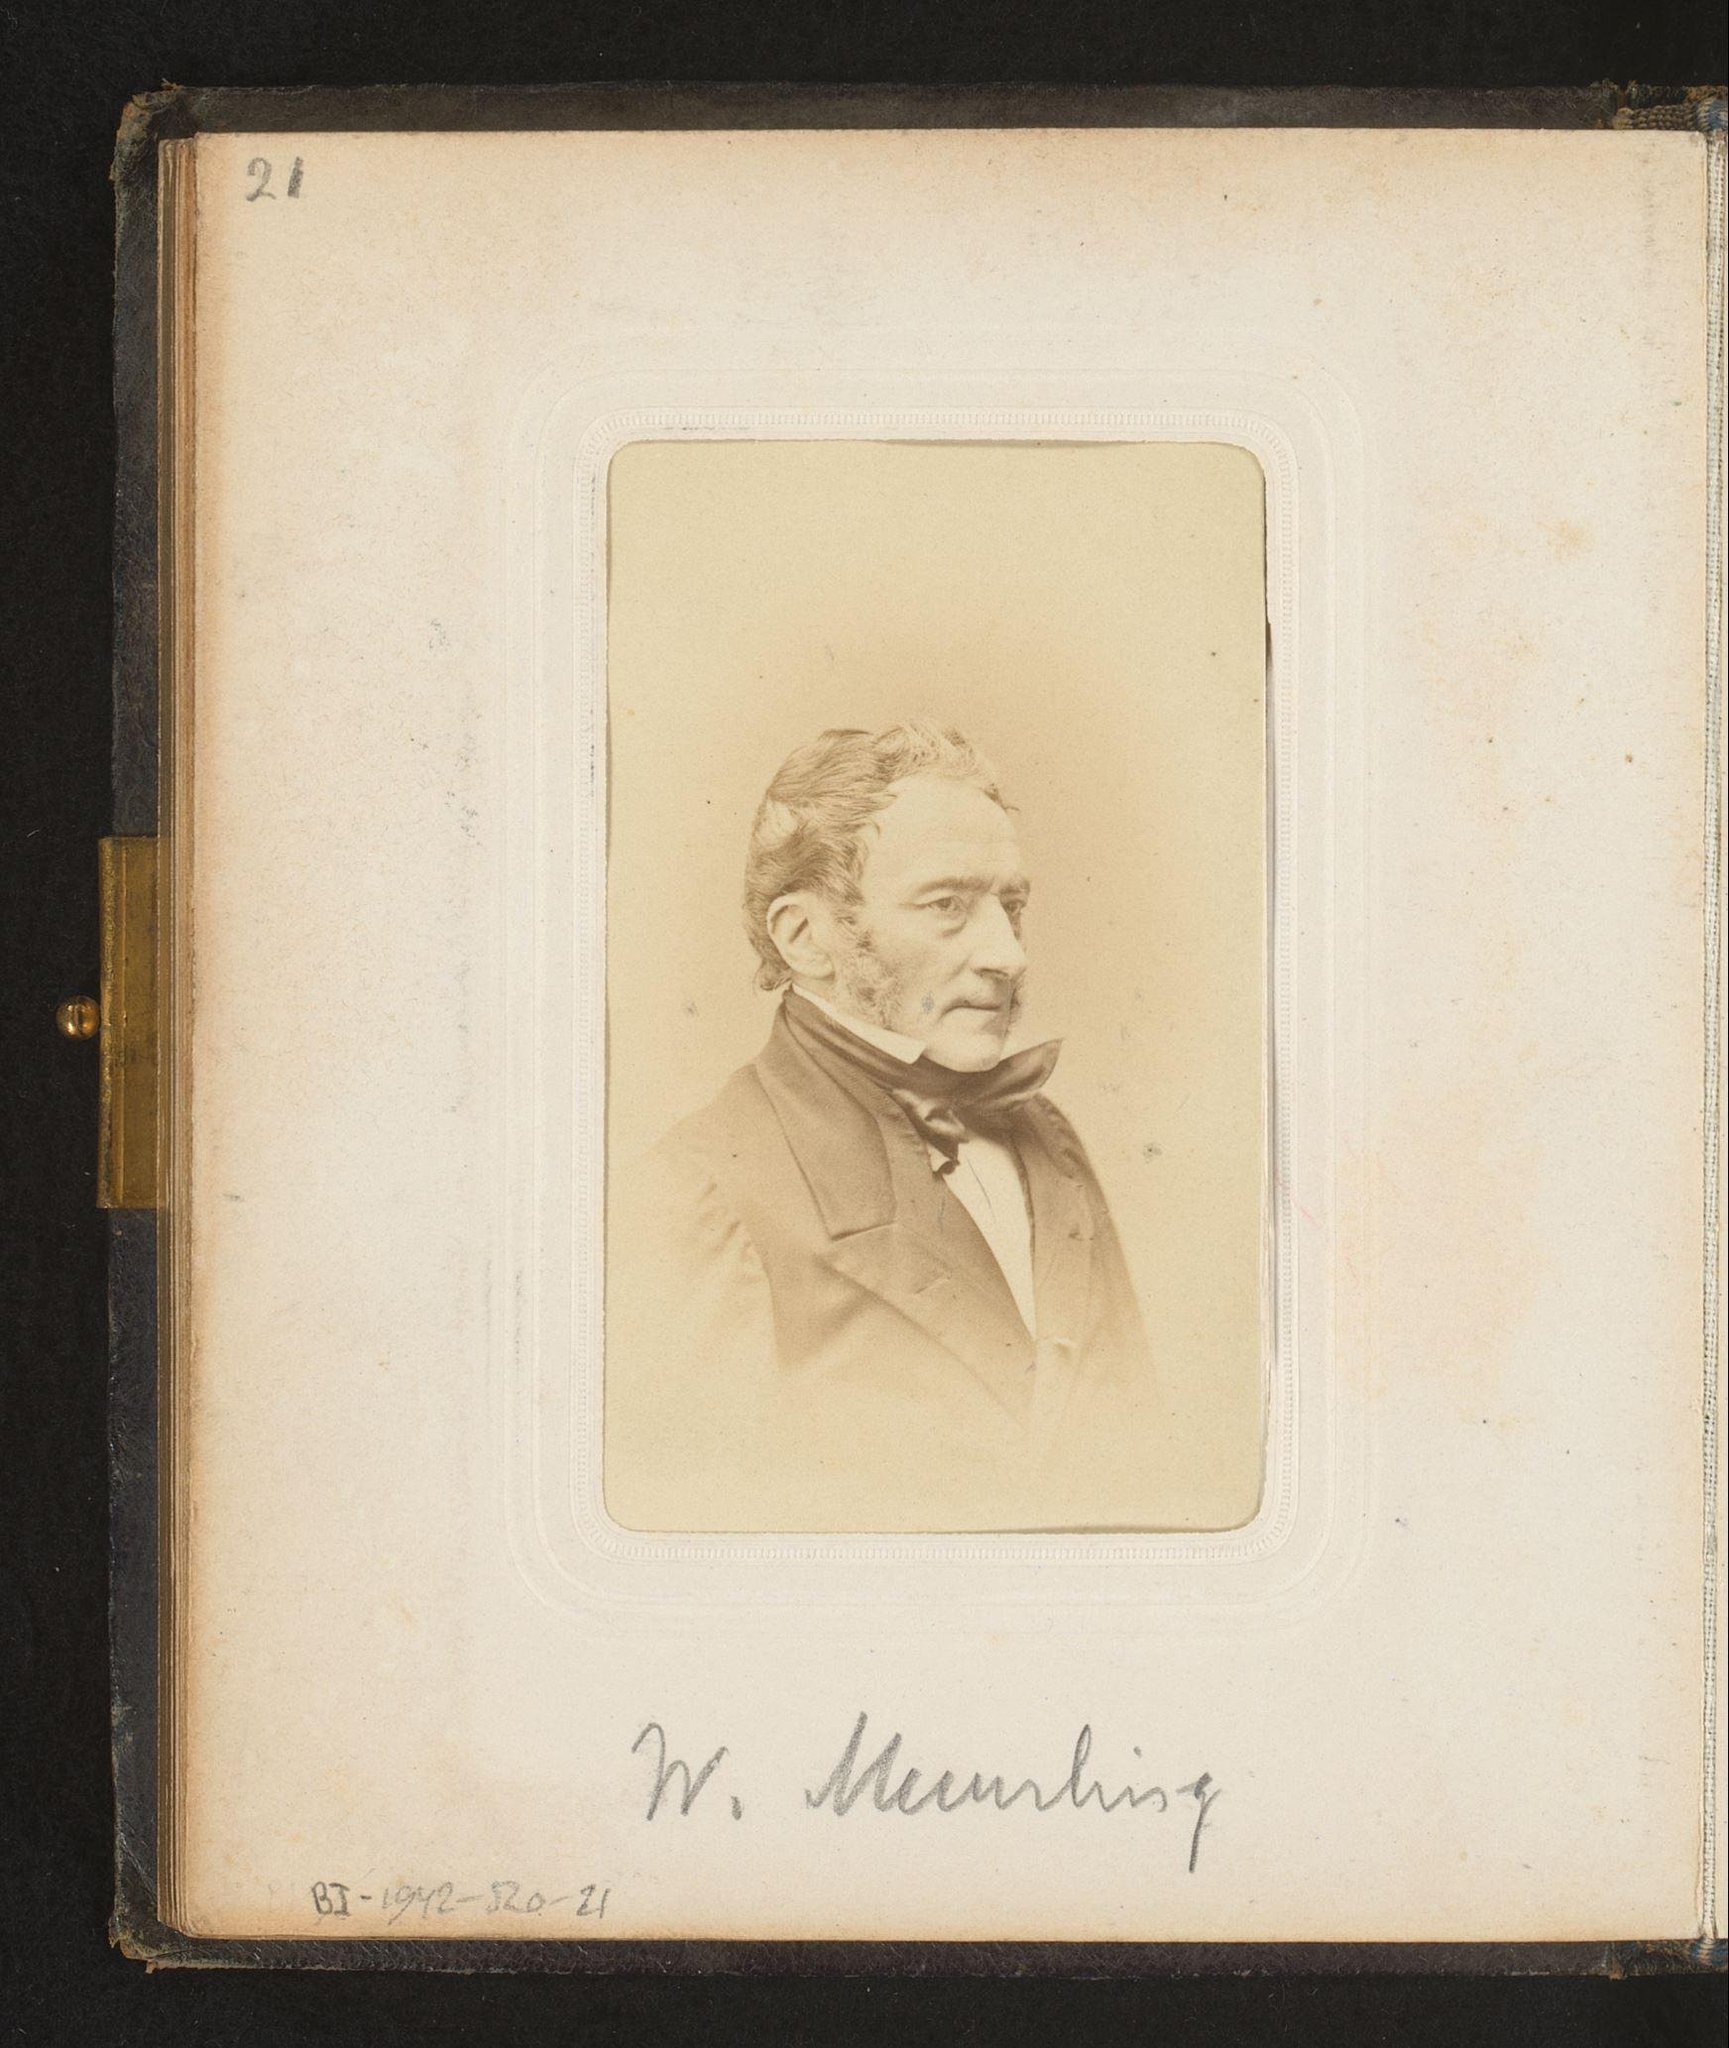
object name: photograph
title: Portret van Willem Muurling, hoogleraar in de faculteit Godgeleerdheid aan de universiteit van Groningen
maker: johannes hinderikus egenberger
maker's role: draughtsman, print maker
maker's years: 1822-1897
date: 1864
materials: cardboard, paper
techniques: albumen print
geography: groningen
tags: historical persons, professor, groningen (province)